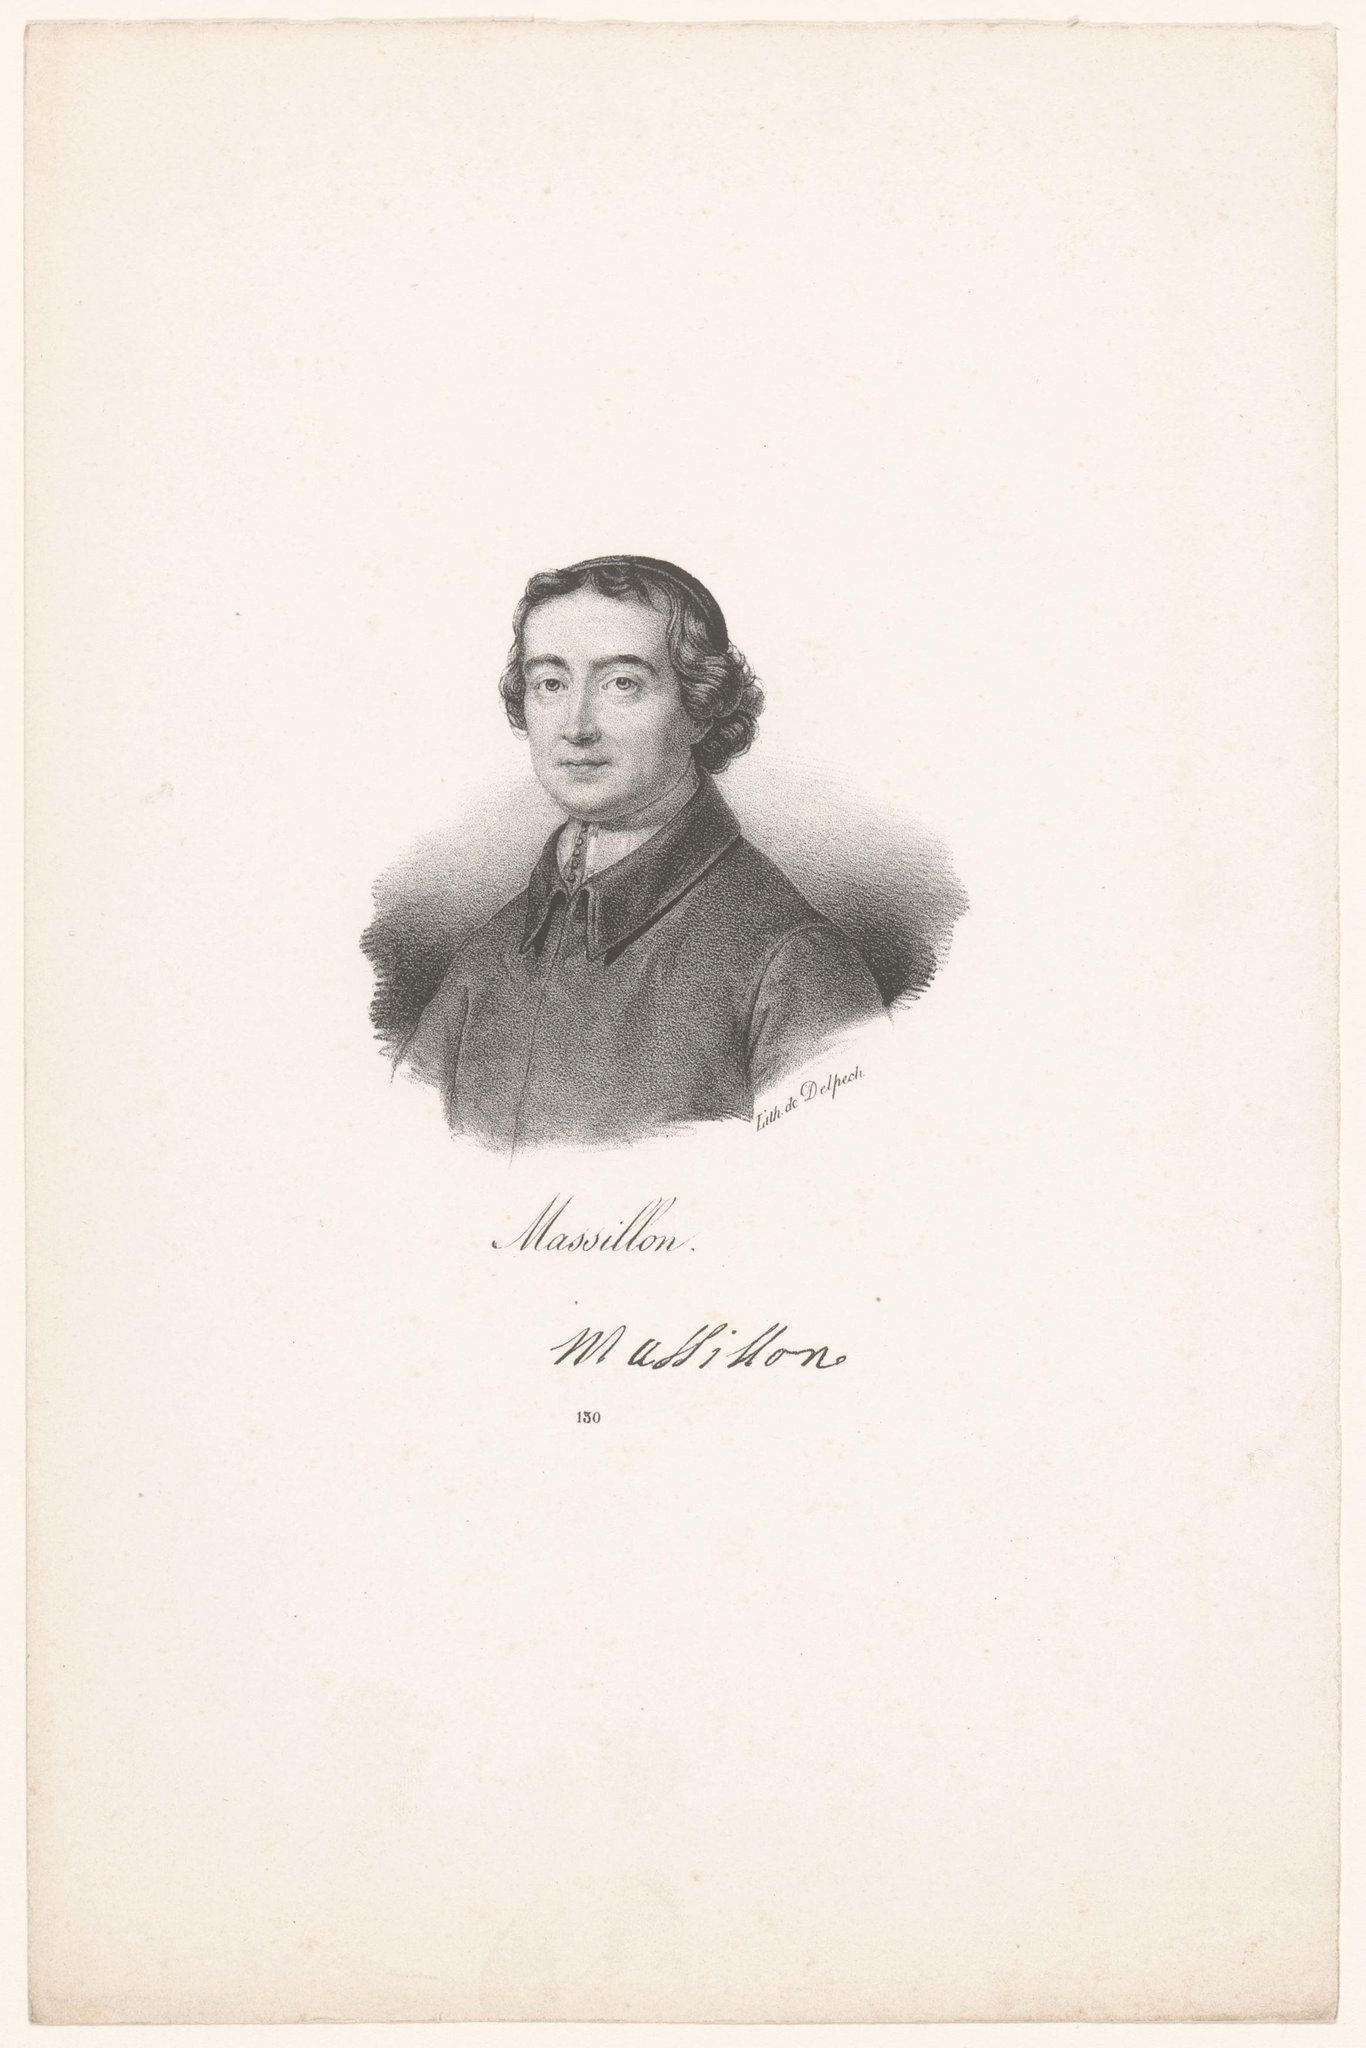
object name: print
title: Portret van Jean-Baptiste Massillon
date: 1818-1842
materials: paper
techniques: lithograph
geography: paris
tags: historical persons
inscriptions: collector's mark: Lugt 2228a